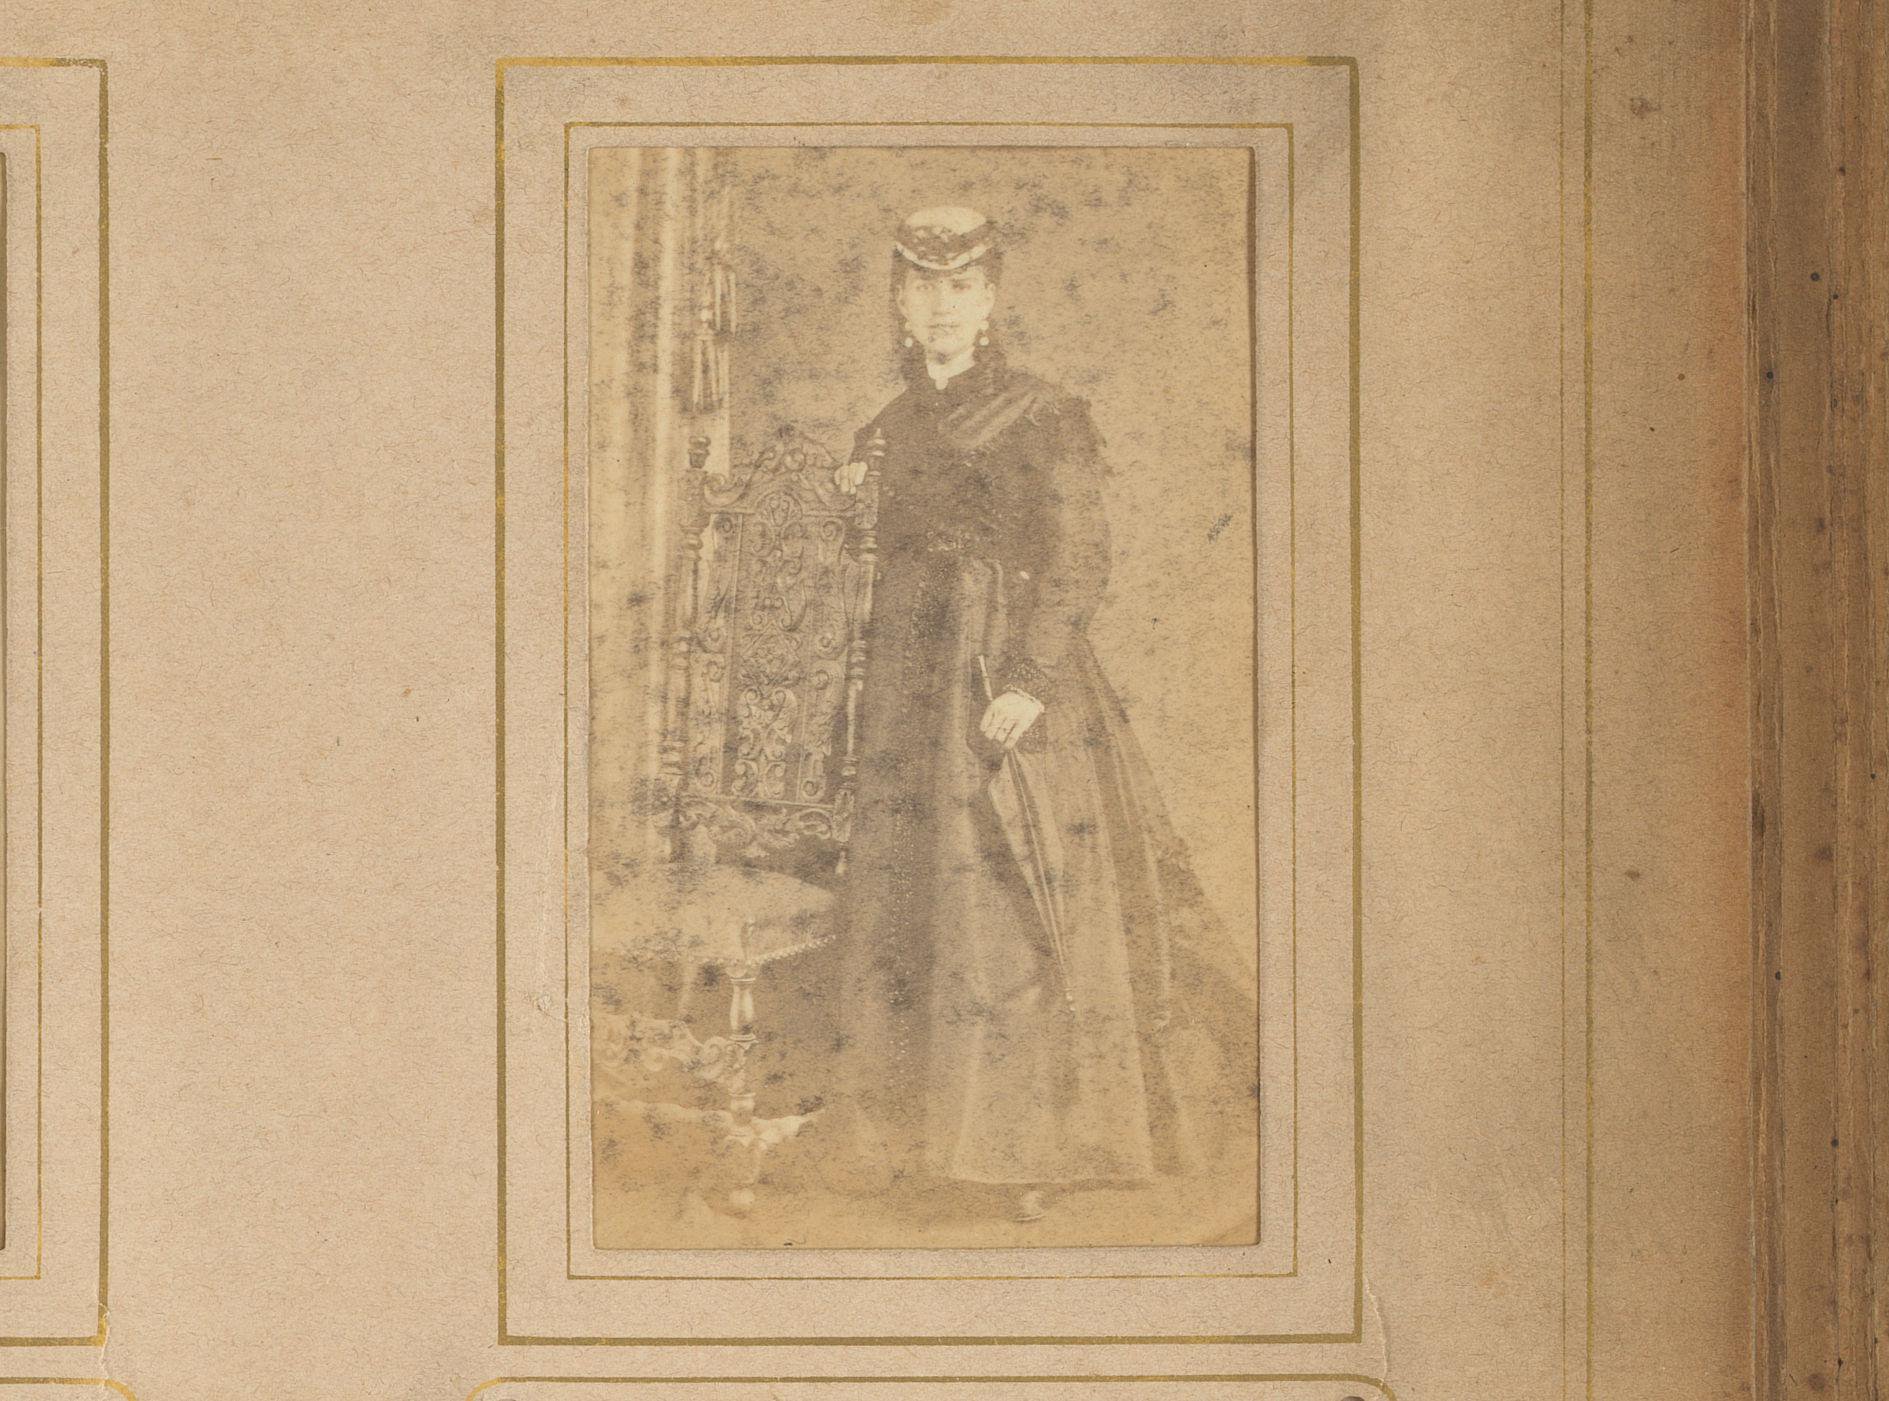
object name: carte de visite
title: Portret van een vrouw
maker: Anonymous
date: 1860-1900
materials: cardboard, photographic support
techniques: albumen print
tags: adult woman, historical persons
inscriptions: name: ‘Brand Frères Bruxelles’